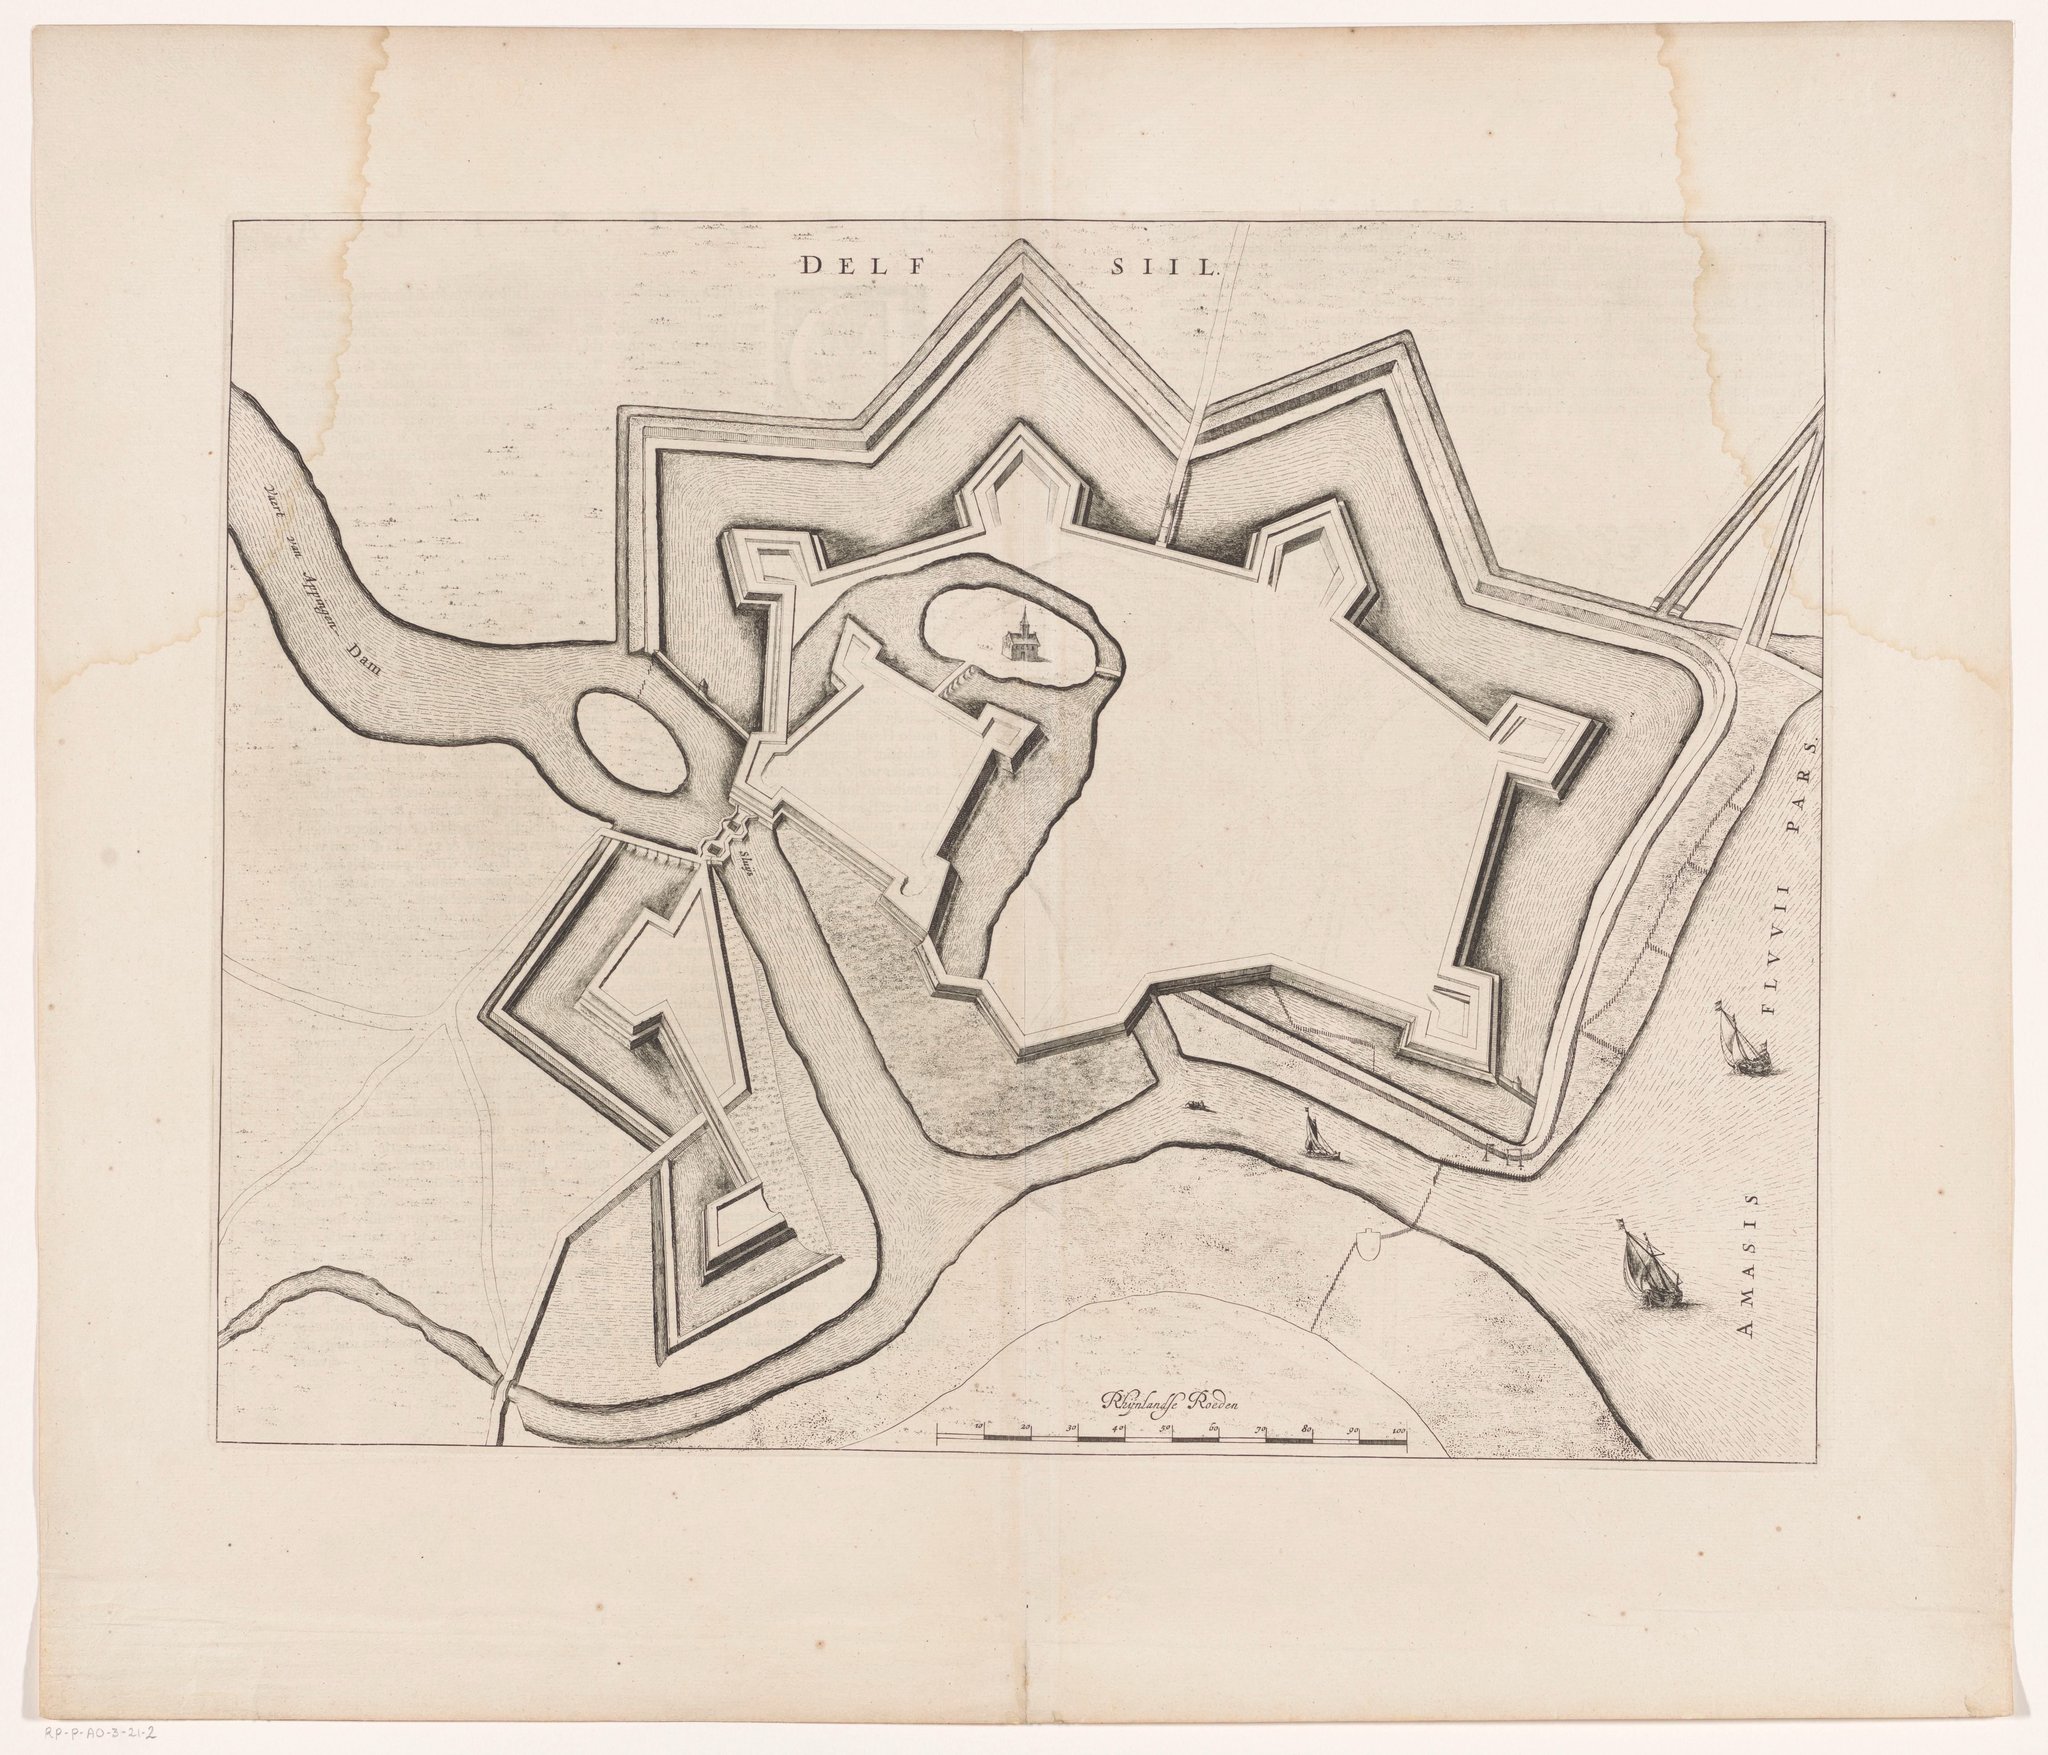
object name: print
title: Vestingplattegrond van Delfzijl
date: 1652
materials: paper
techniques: engraving, etching, letterpress printing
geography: amsterdam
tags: fortress, maps of cities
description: Prent gebruikt in: Blaeu, Johannes Willemszoon. Novum ac magnum theatrum urbium Belgicae (...). 2 delen. 3e druk. Amsterdam: Johannes Willemszoon Blaeu, 1652, dl. 1.